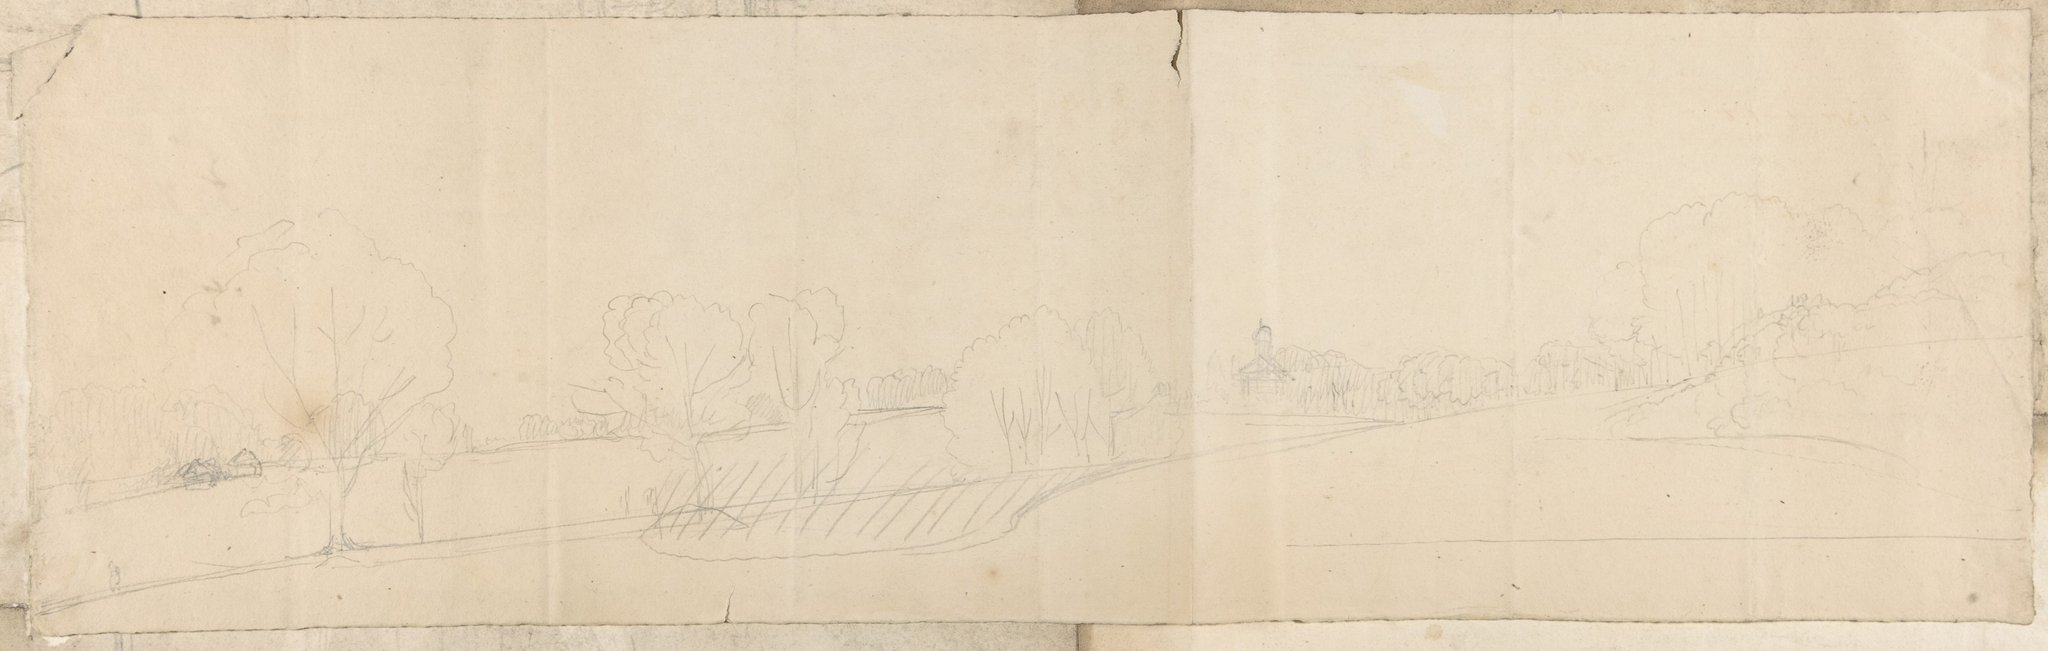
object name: drawing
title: Landscape Sketch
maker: anonymous, british, 19th century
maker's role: artist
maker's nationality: british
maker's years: 1800-1900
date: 1824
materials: graphite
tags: landscapes